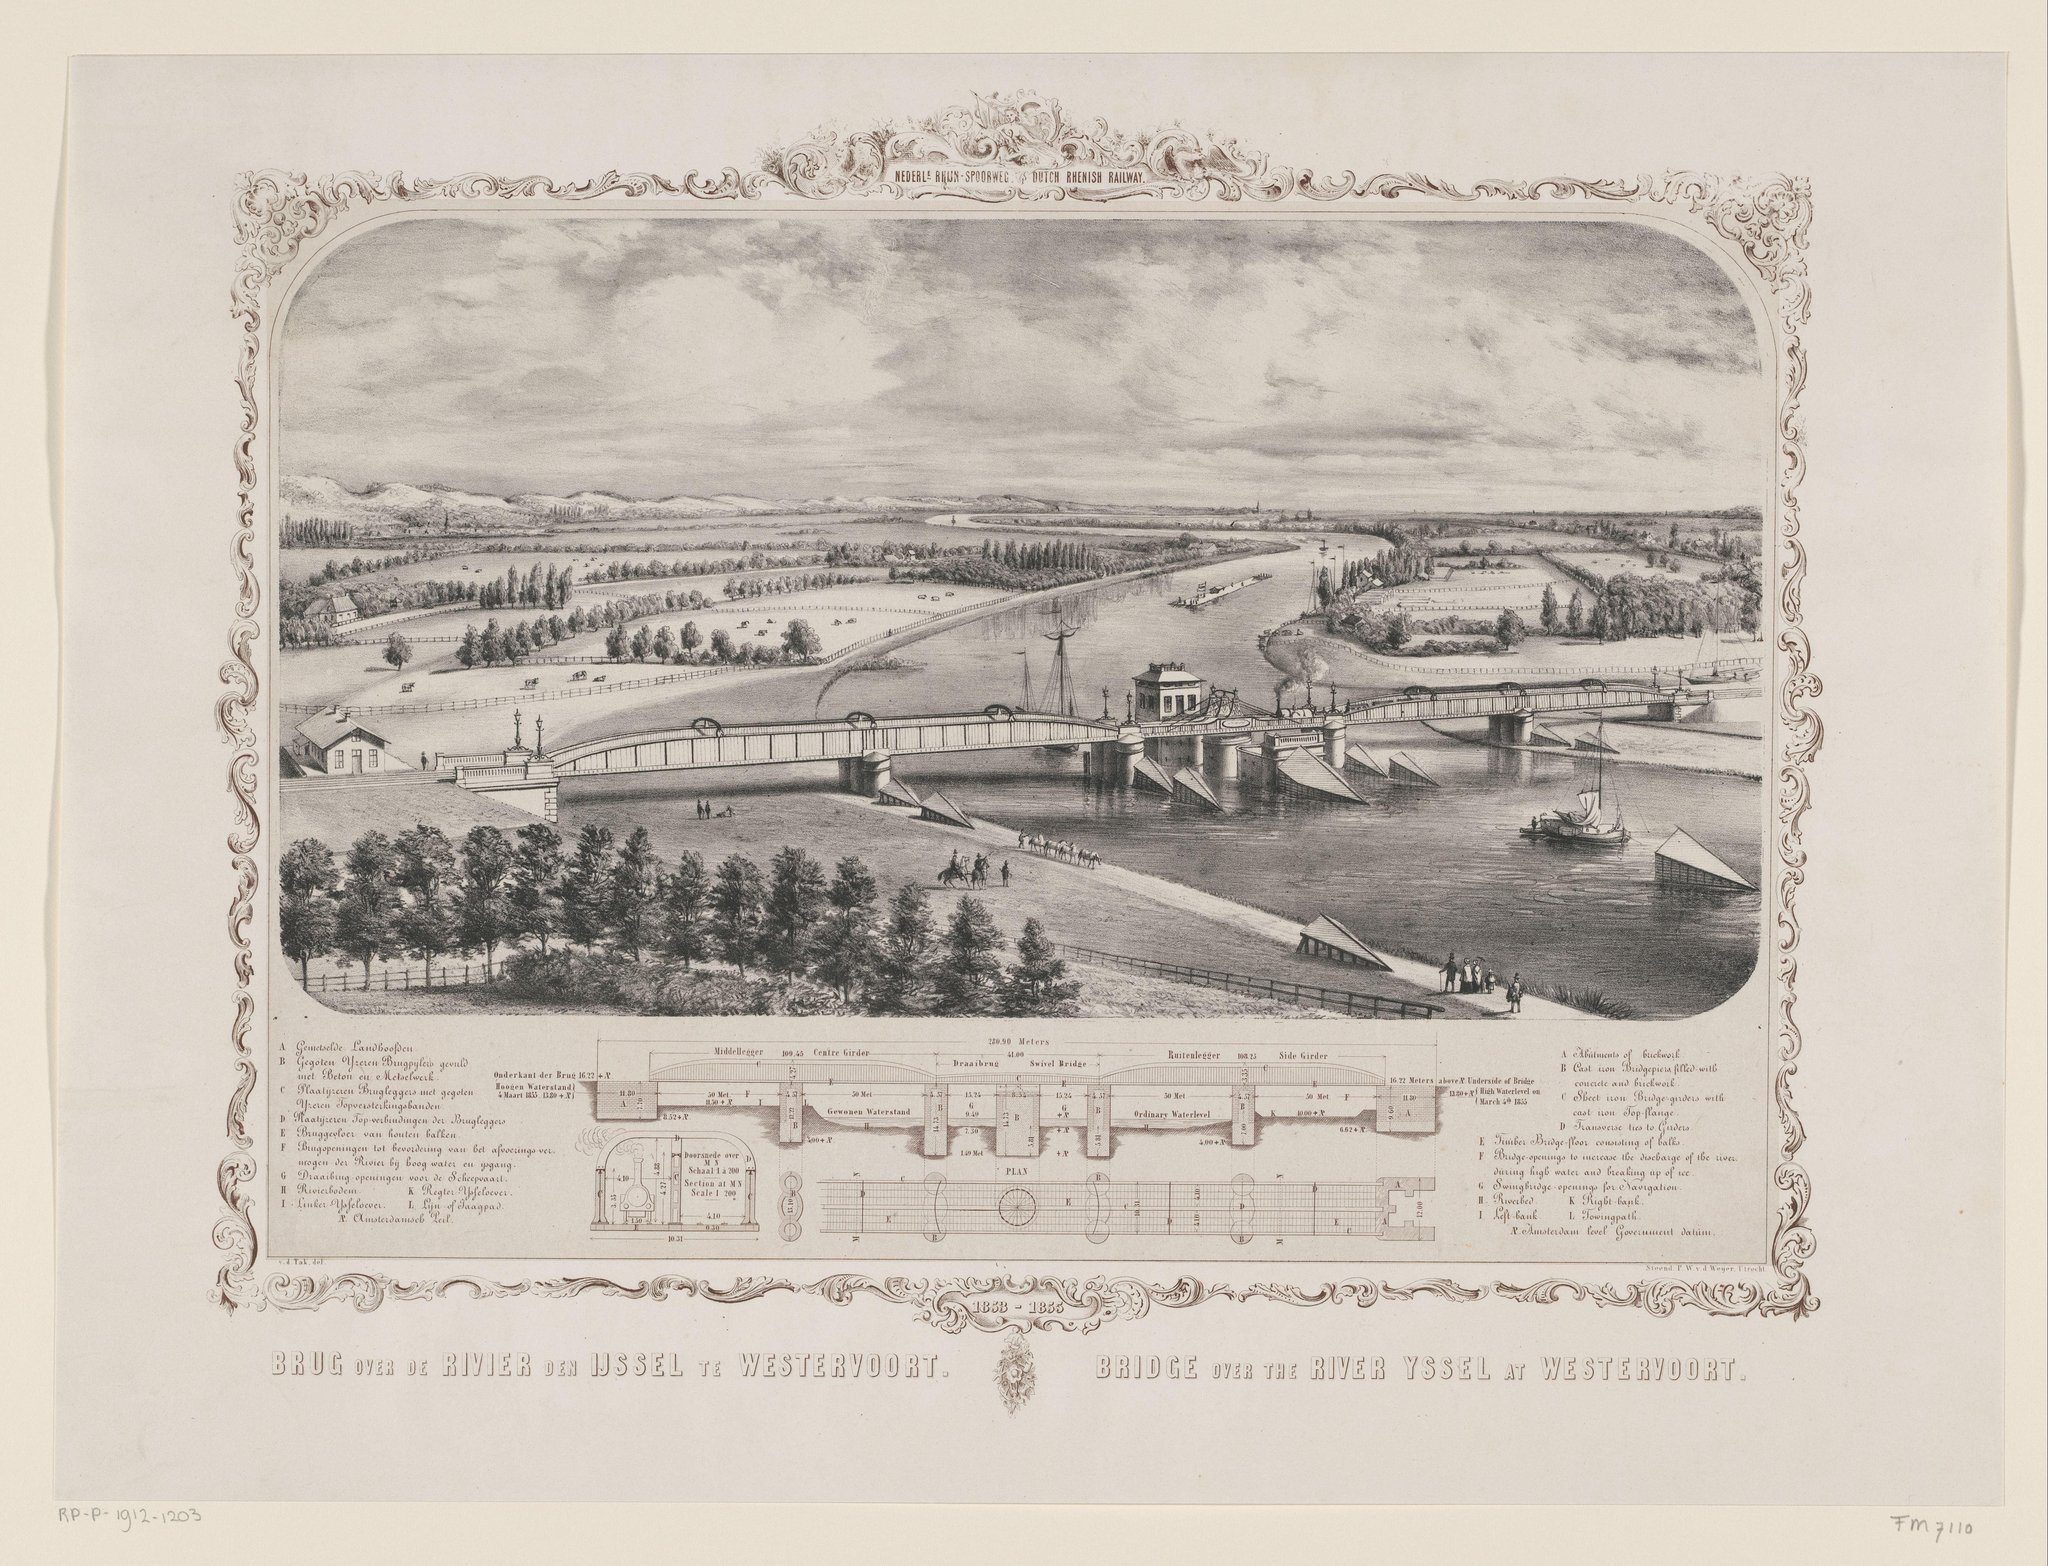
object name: print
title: Nederl.e Rhijn-spoorweg / Dutch Rhenish railway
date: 1855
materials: paper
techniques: lithograph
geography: netherlands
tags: railway, train, bridge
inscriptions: collector's mark: Lugt 2228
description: Gezicht op de eerste spoorburg, gebouwd tussen 1853-1855, over de rivier de IJssel bij Westervoort. Aan de onderzijde technische tekeningen van voor- en bovenaanzicht.